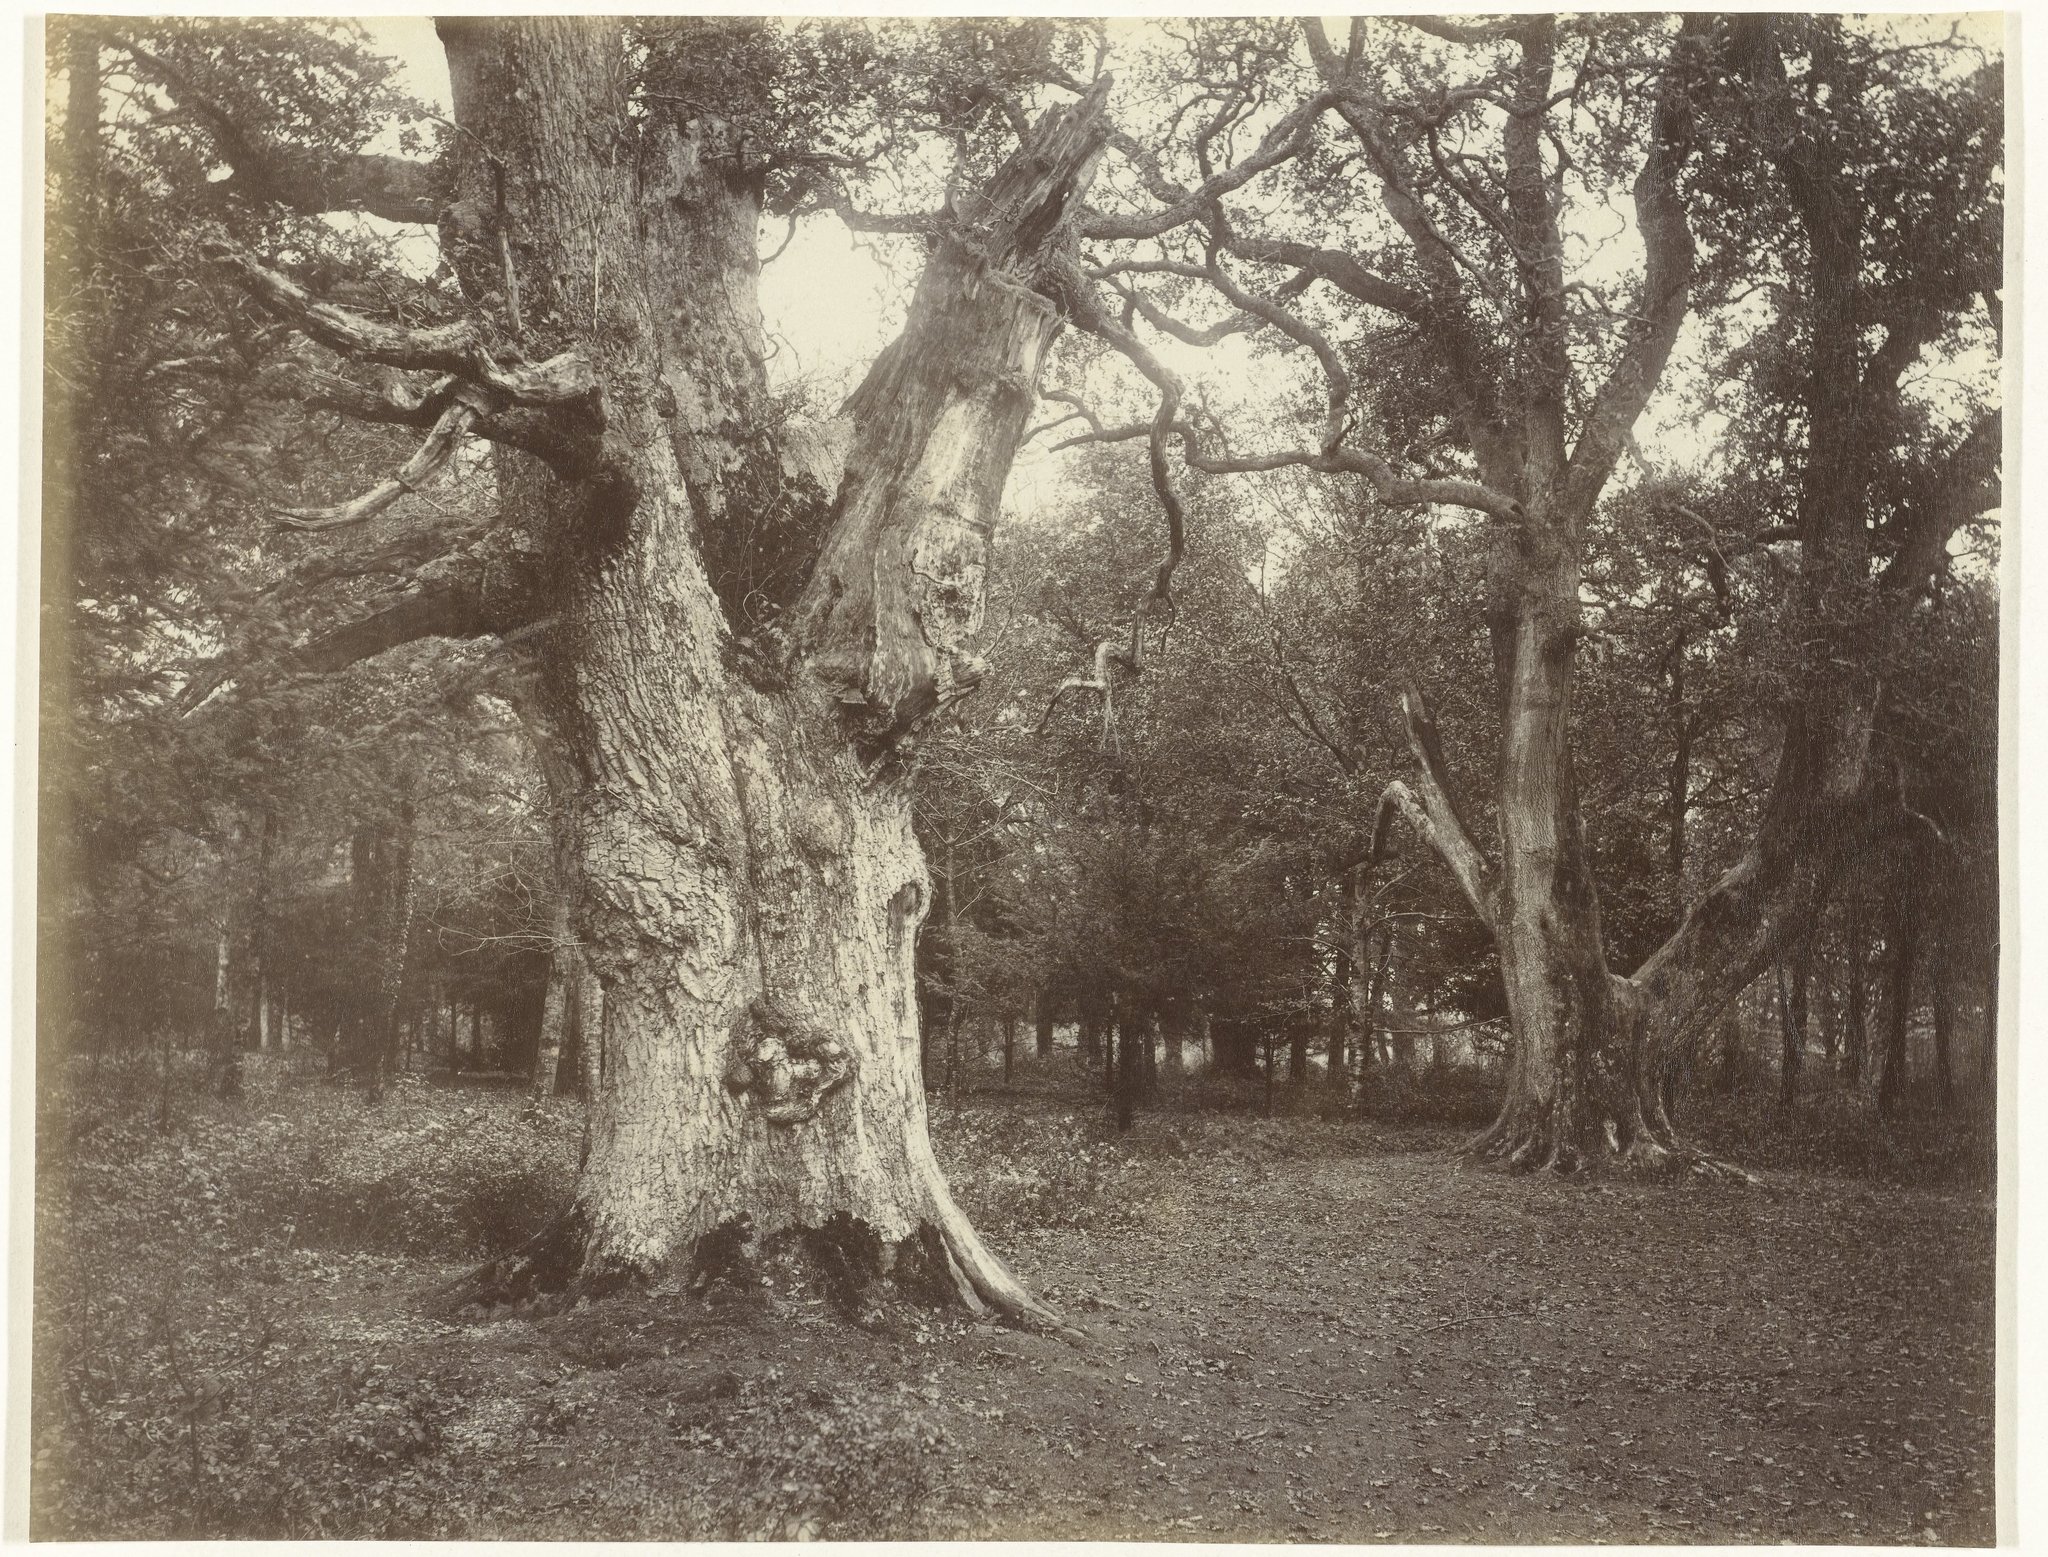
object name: photograph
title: Boomstudie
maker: Anonymous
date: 1855-1900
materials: paper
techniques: albumen print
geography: great britain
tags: trees, great britain